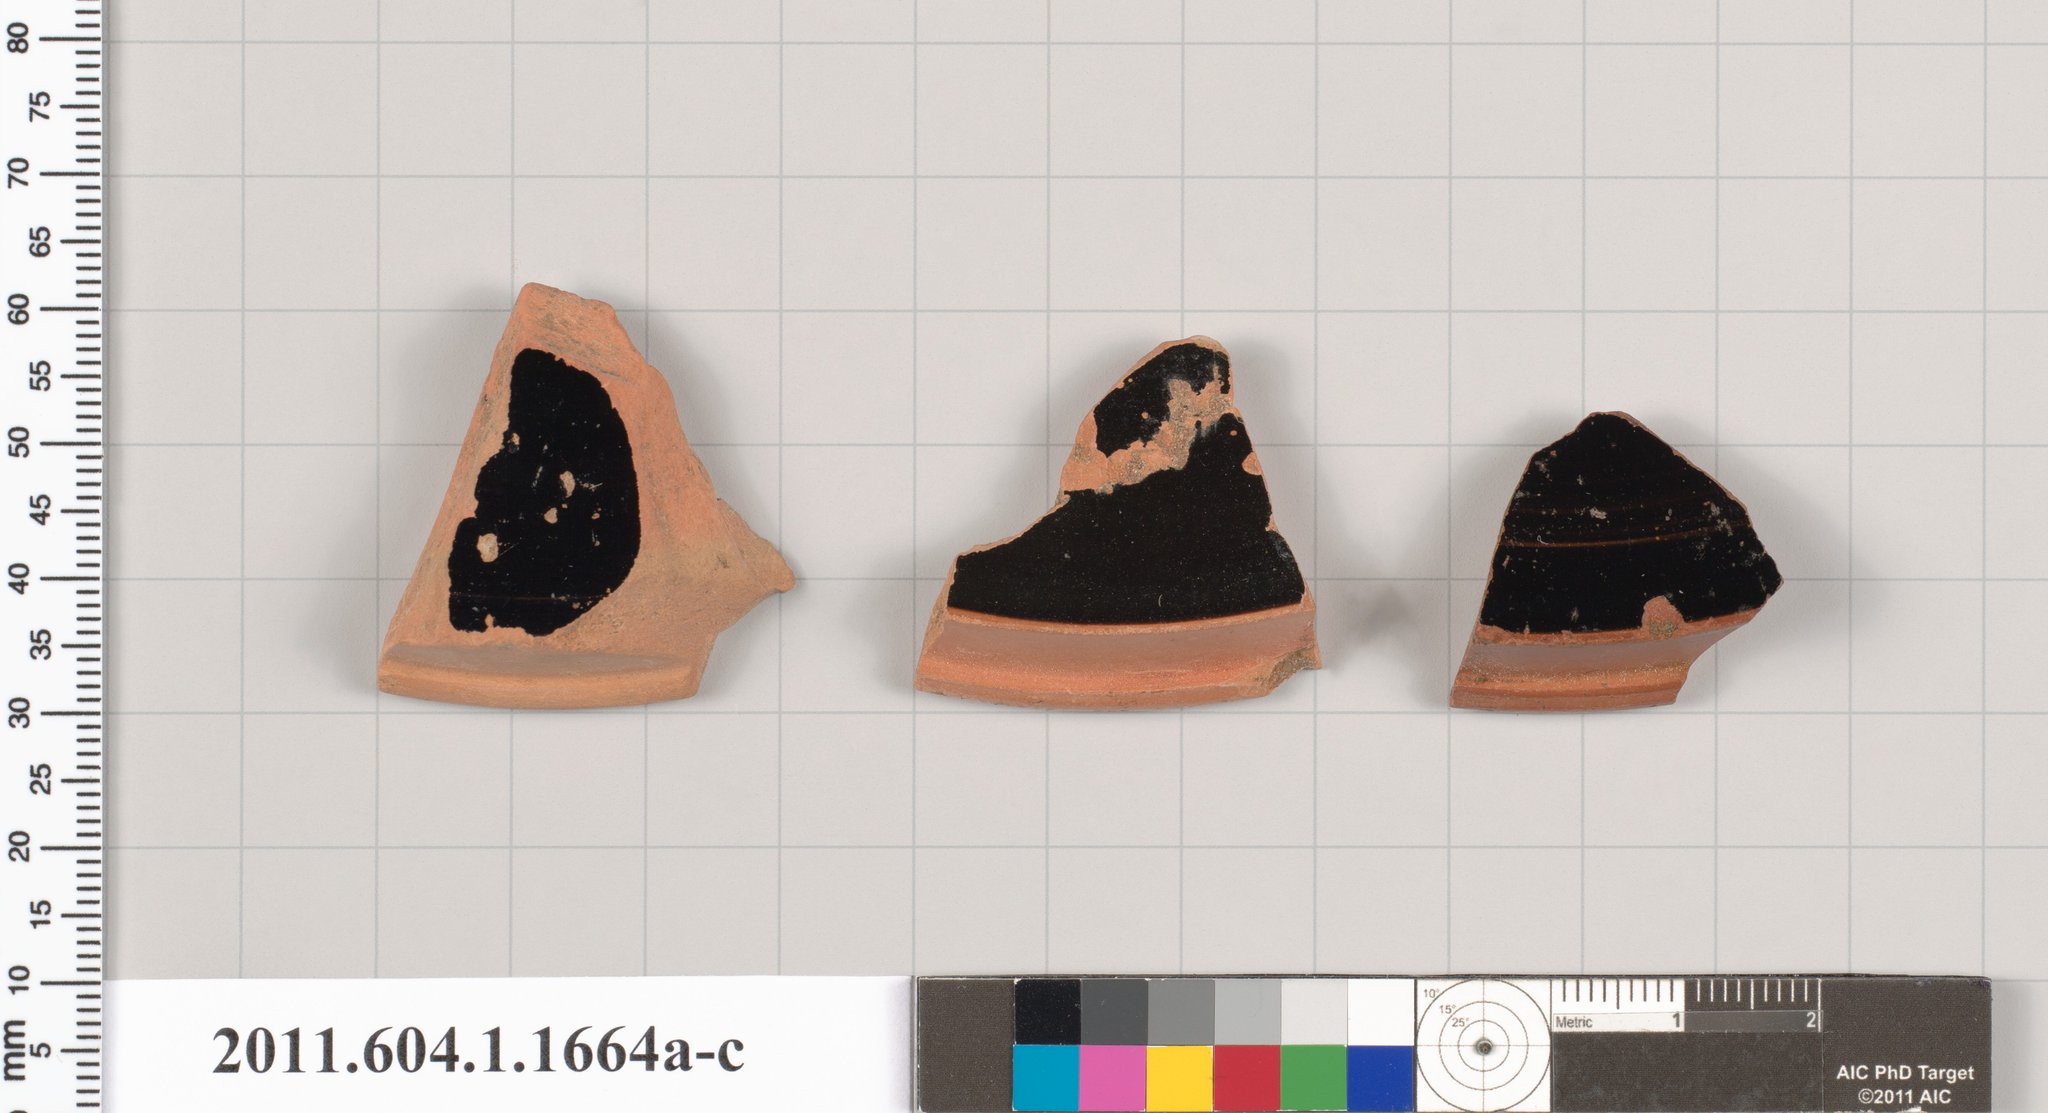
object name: kylix fragment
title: Terracotta fragments of kylikes (drinking cups)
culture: greek, attic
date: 530-510 BCE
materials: terracotta